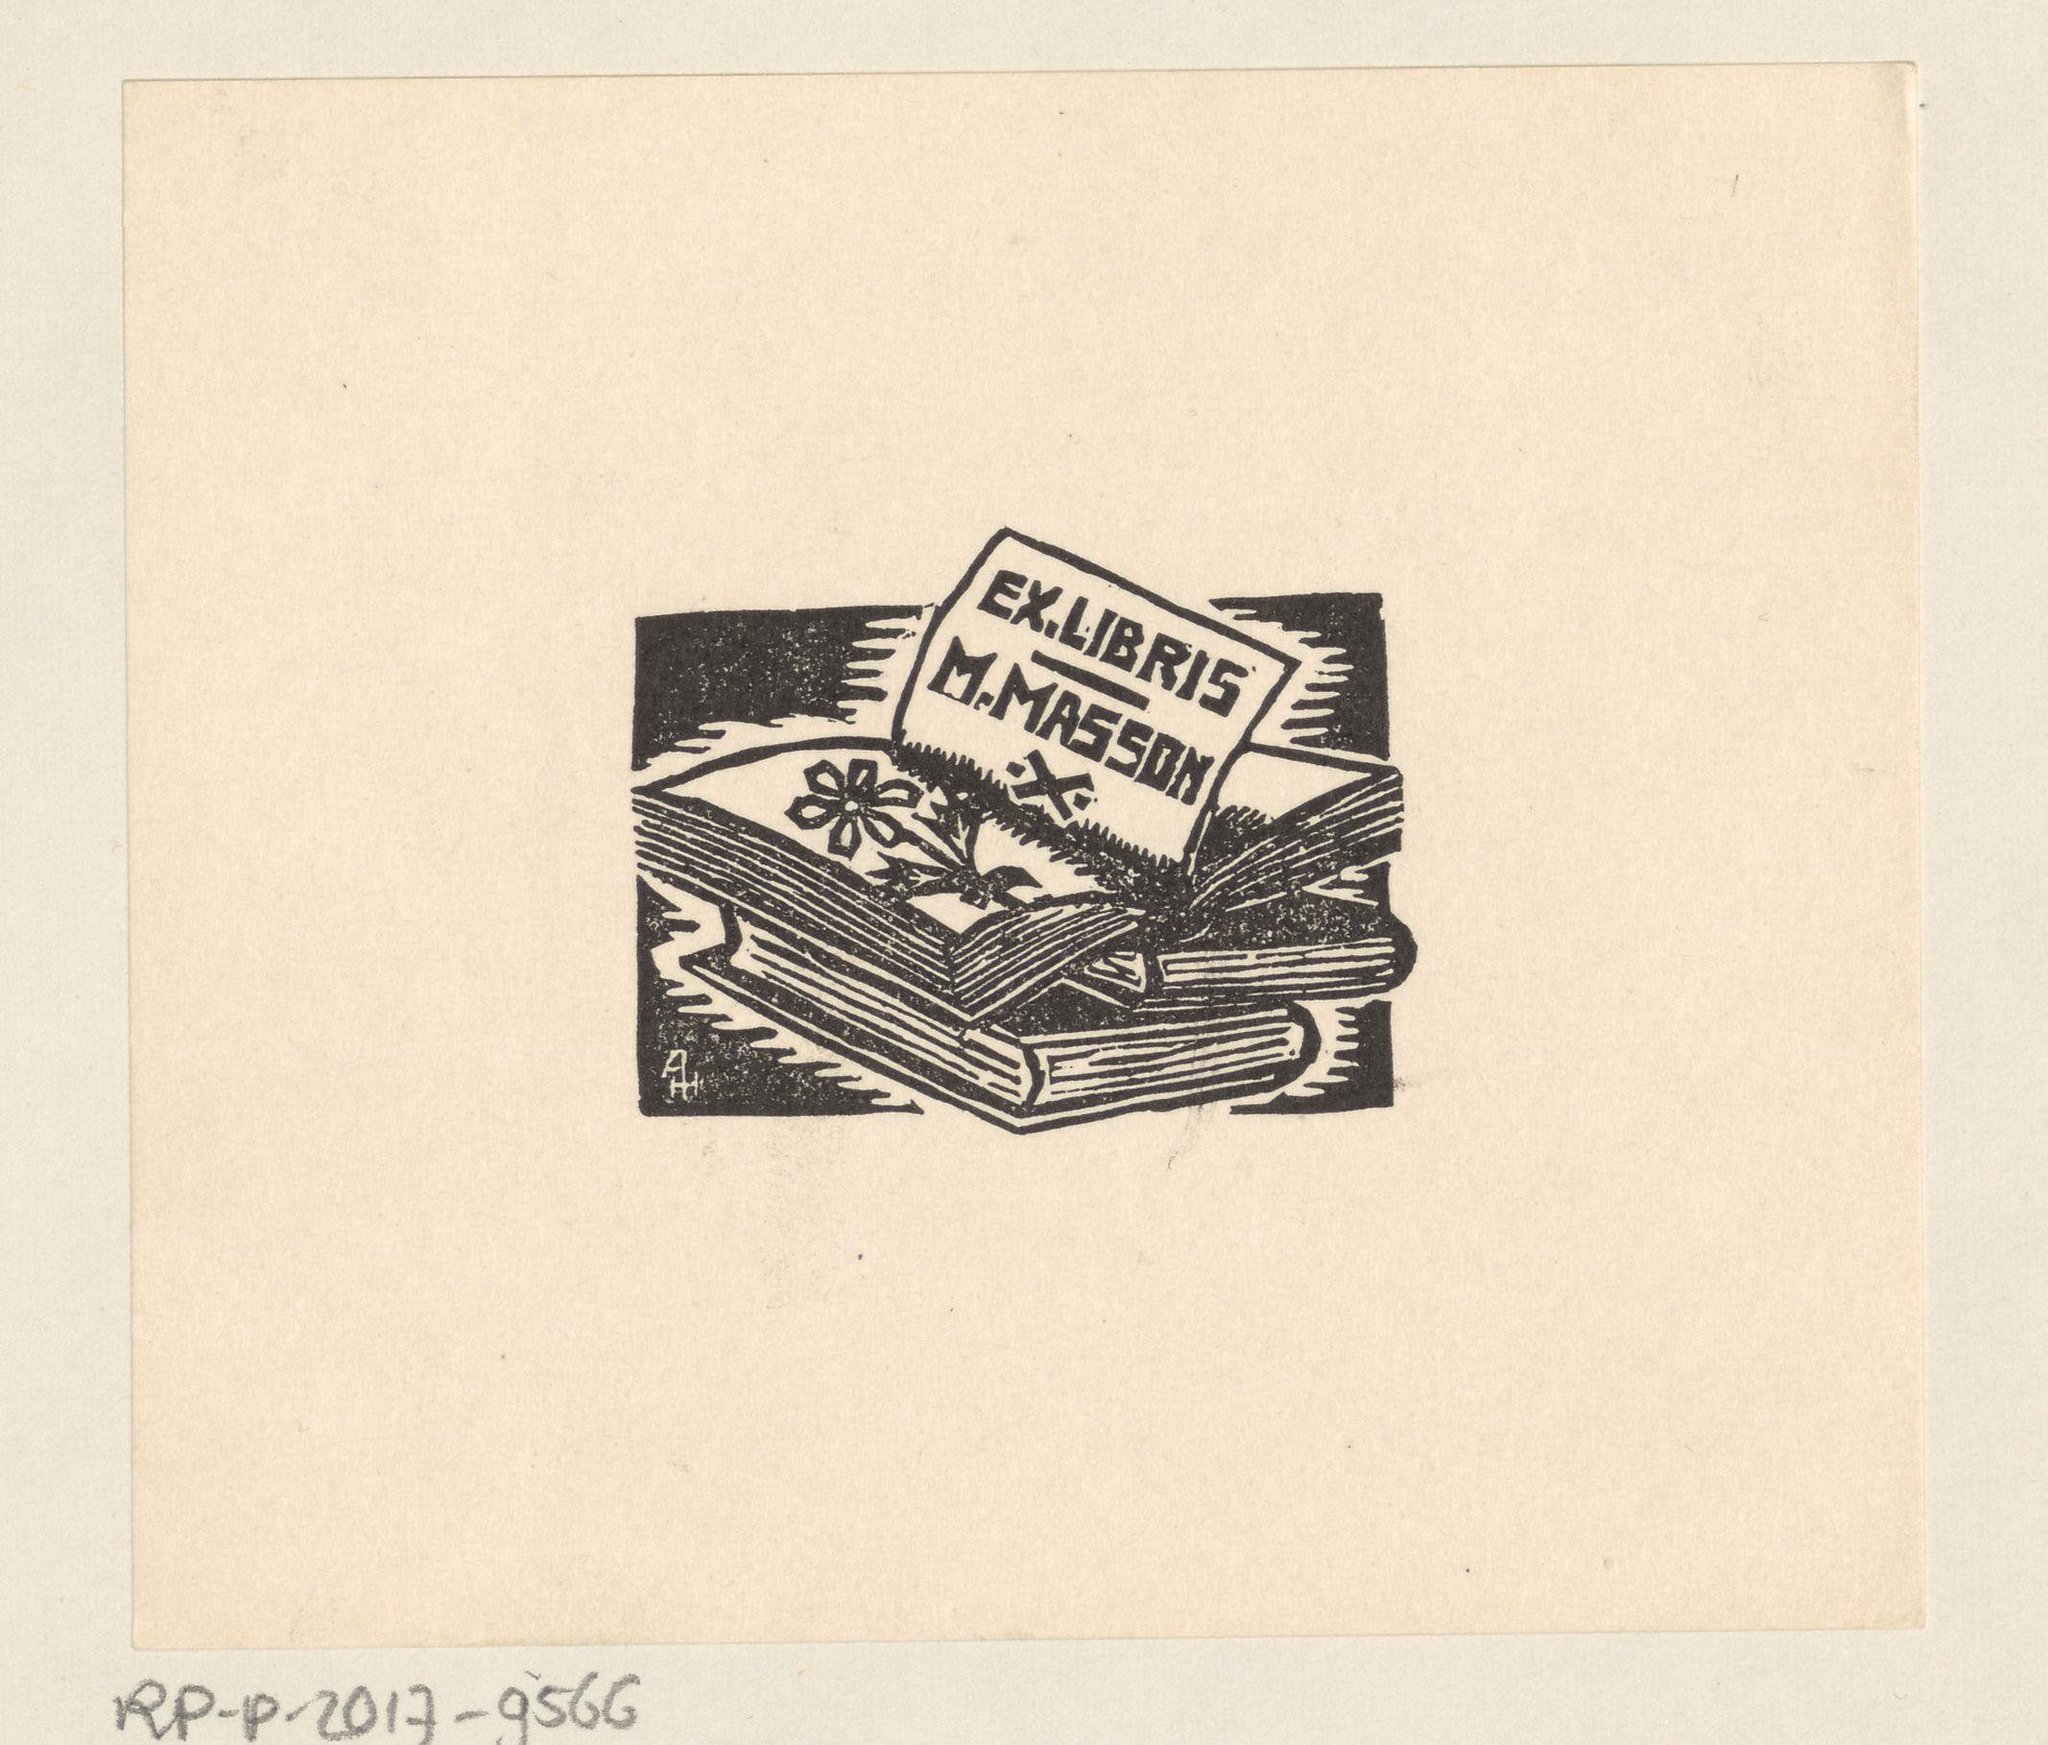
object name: bookplate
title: Ex libris van M. Masson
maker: andré herry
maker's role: print maker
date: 1900-1999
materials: paper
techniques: woodcut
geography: nancy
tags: flowers, book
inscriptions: workshop stamp: ‘Gravure nois no. 57/ de A. Herry, Nancy’